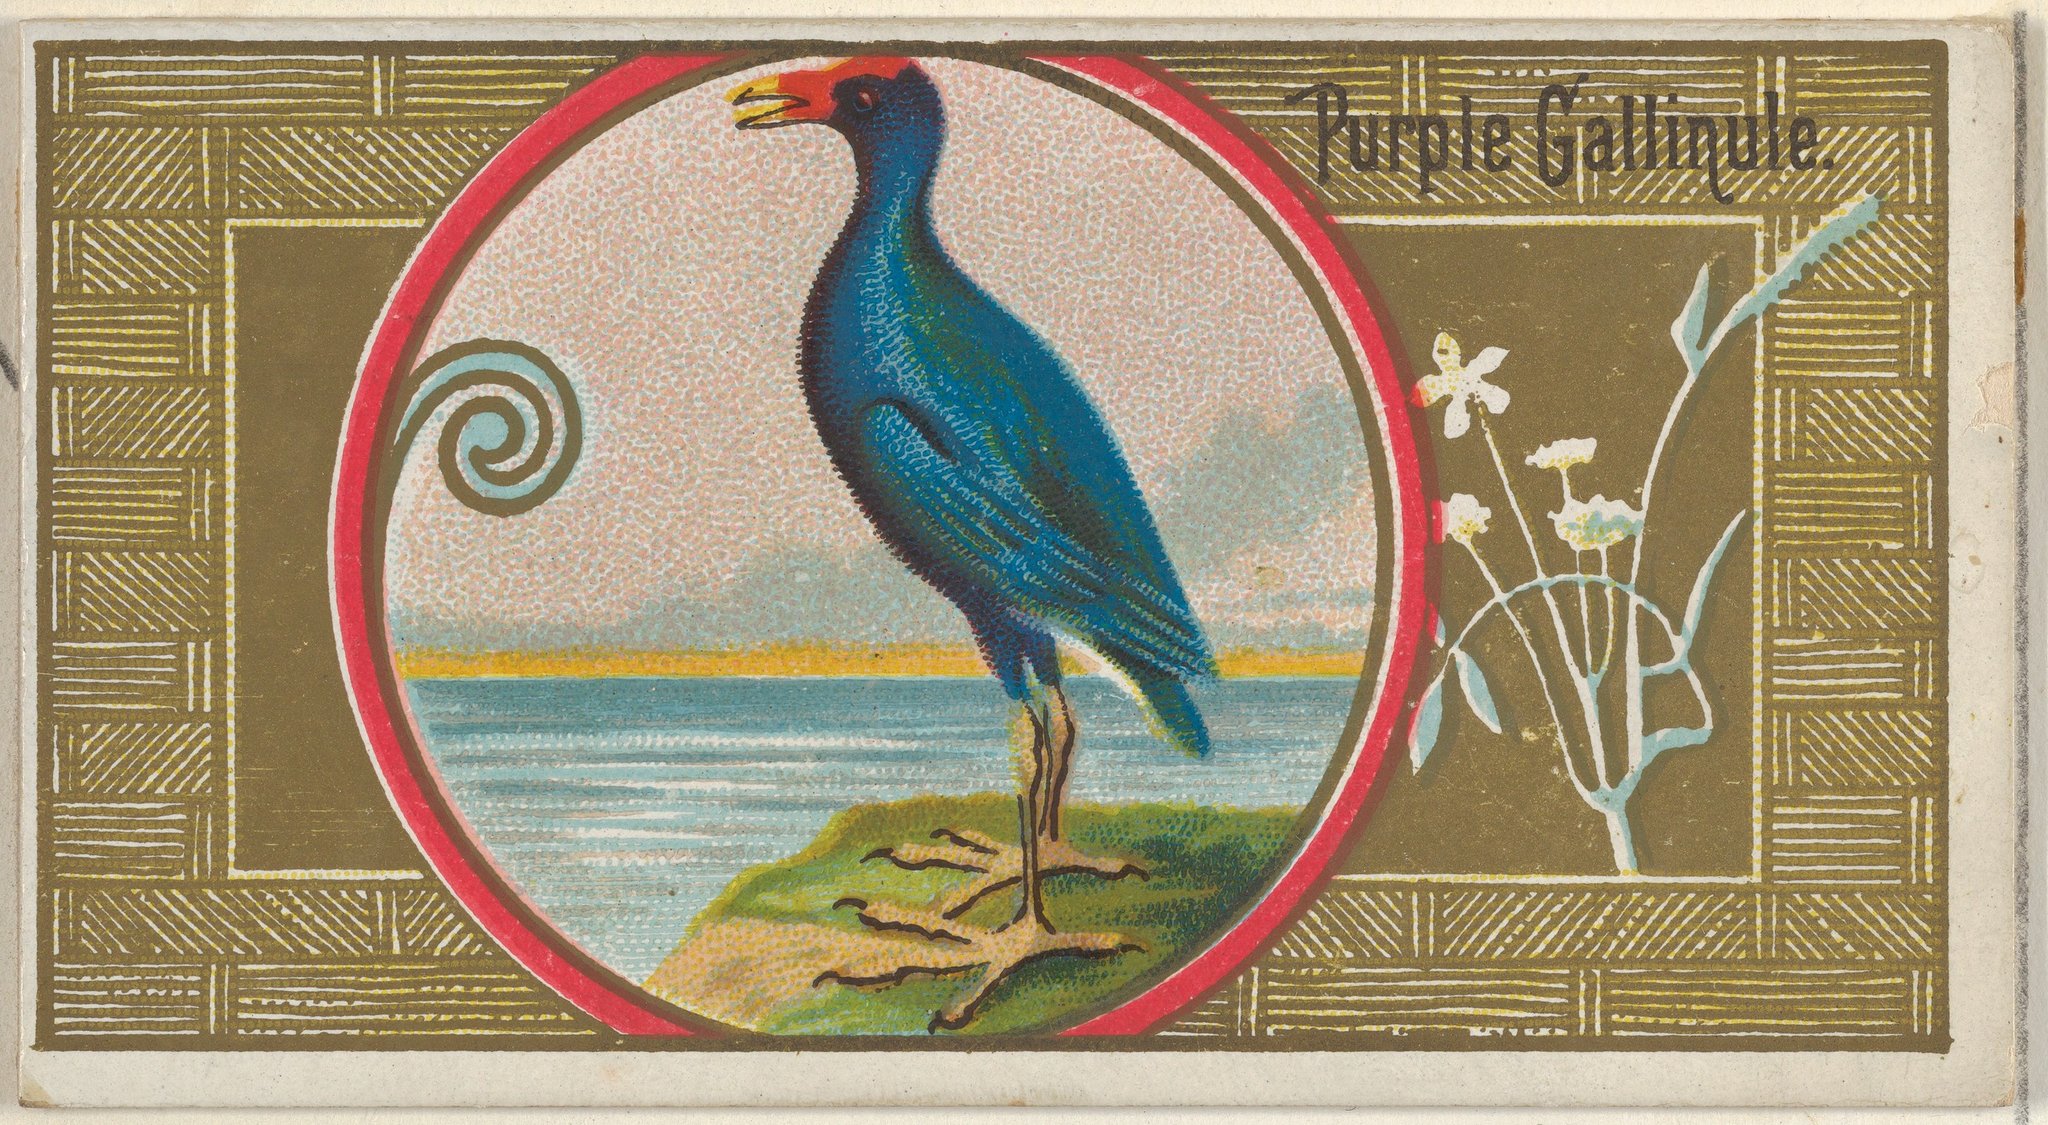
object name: print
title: Purple Gallinule, from the Game Birds series (N13) for Allen & Ginter Cigarettes Brands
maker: allen & ginter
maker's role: publisher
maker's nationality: american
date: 1889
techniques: color lithograph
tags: birds